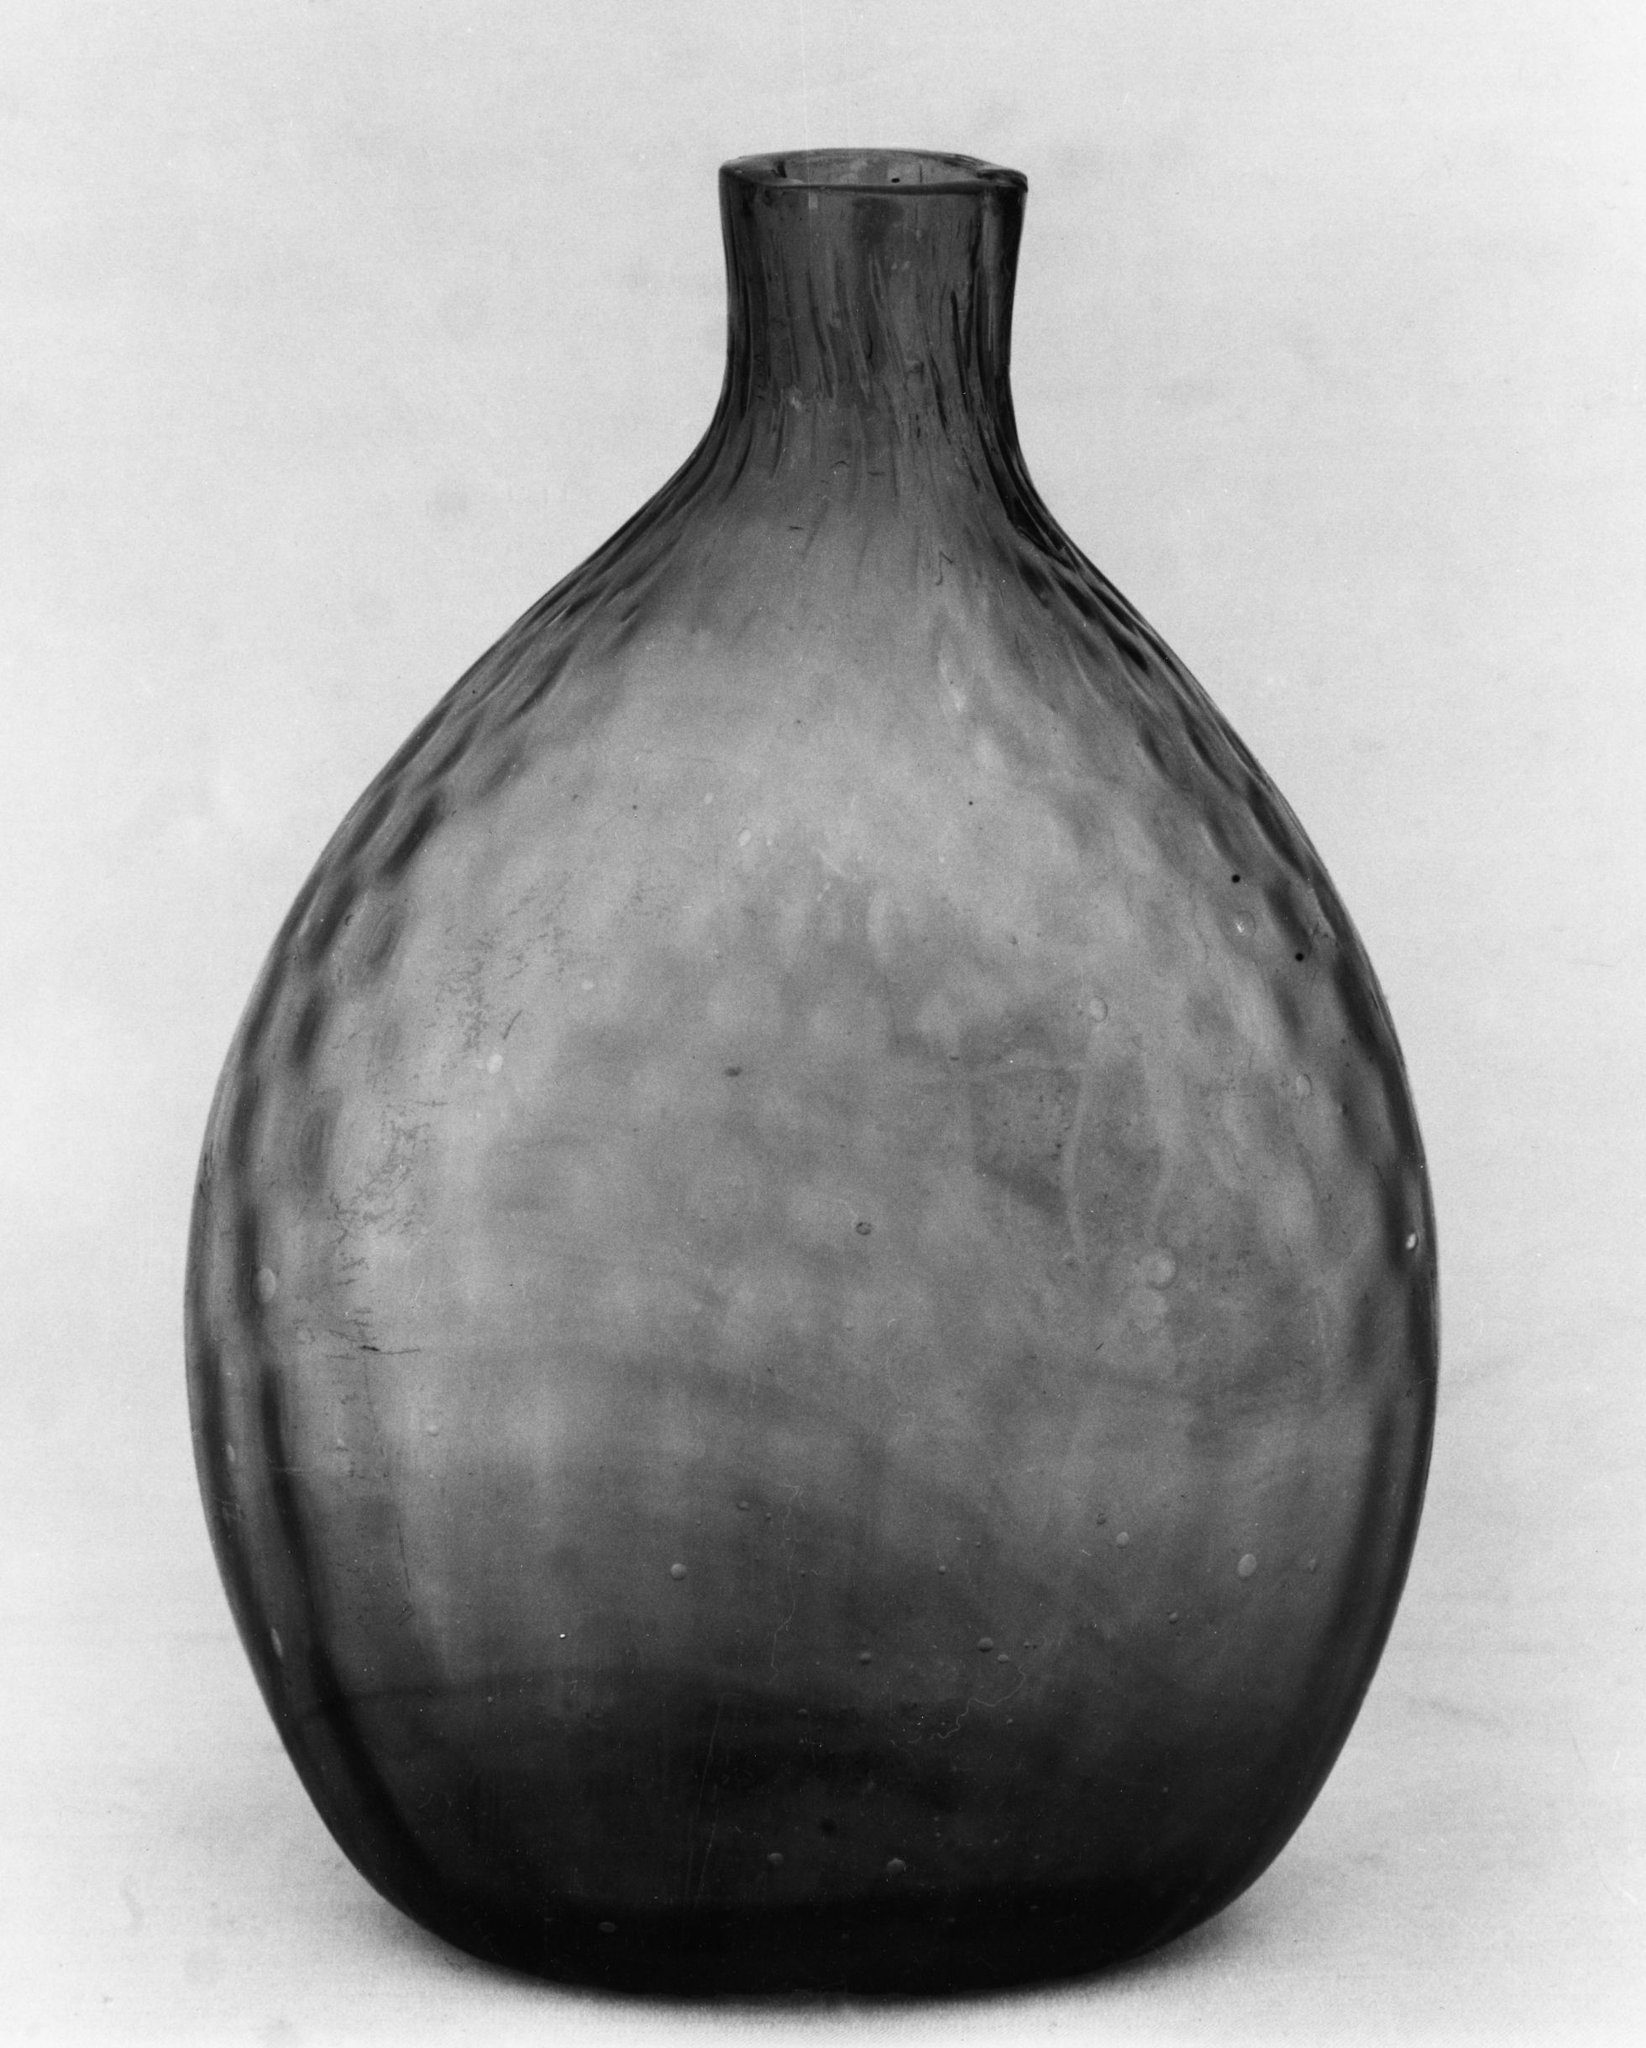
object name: flask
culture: american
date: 1750-1800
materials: glass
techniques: glassblowing, molding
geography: united states